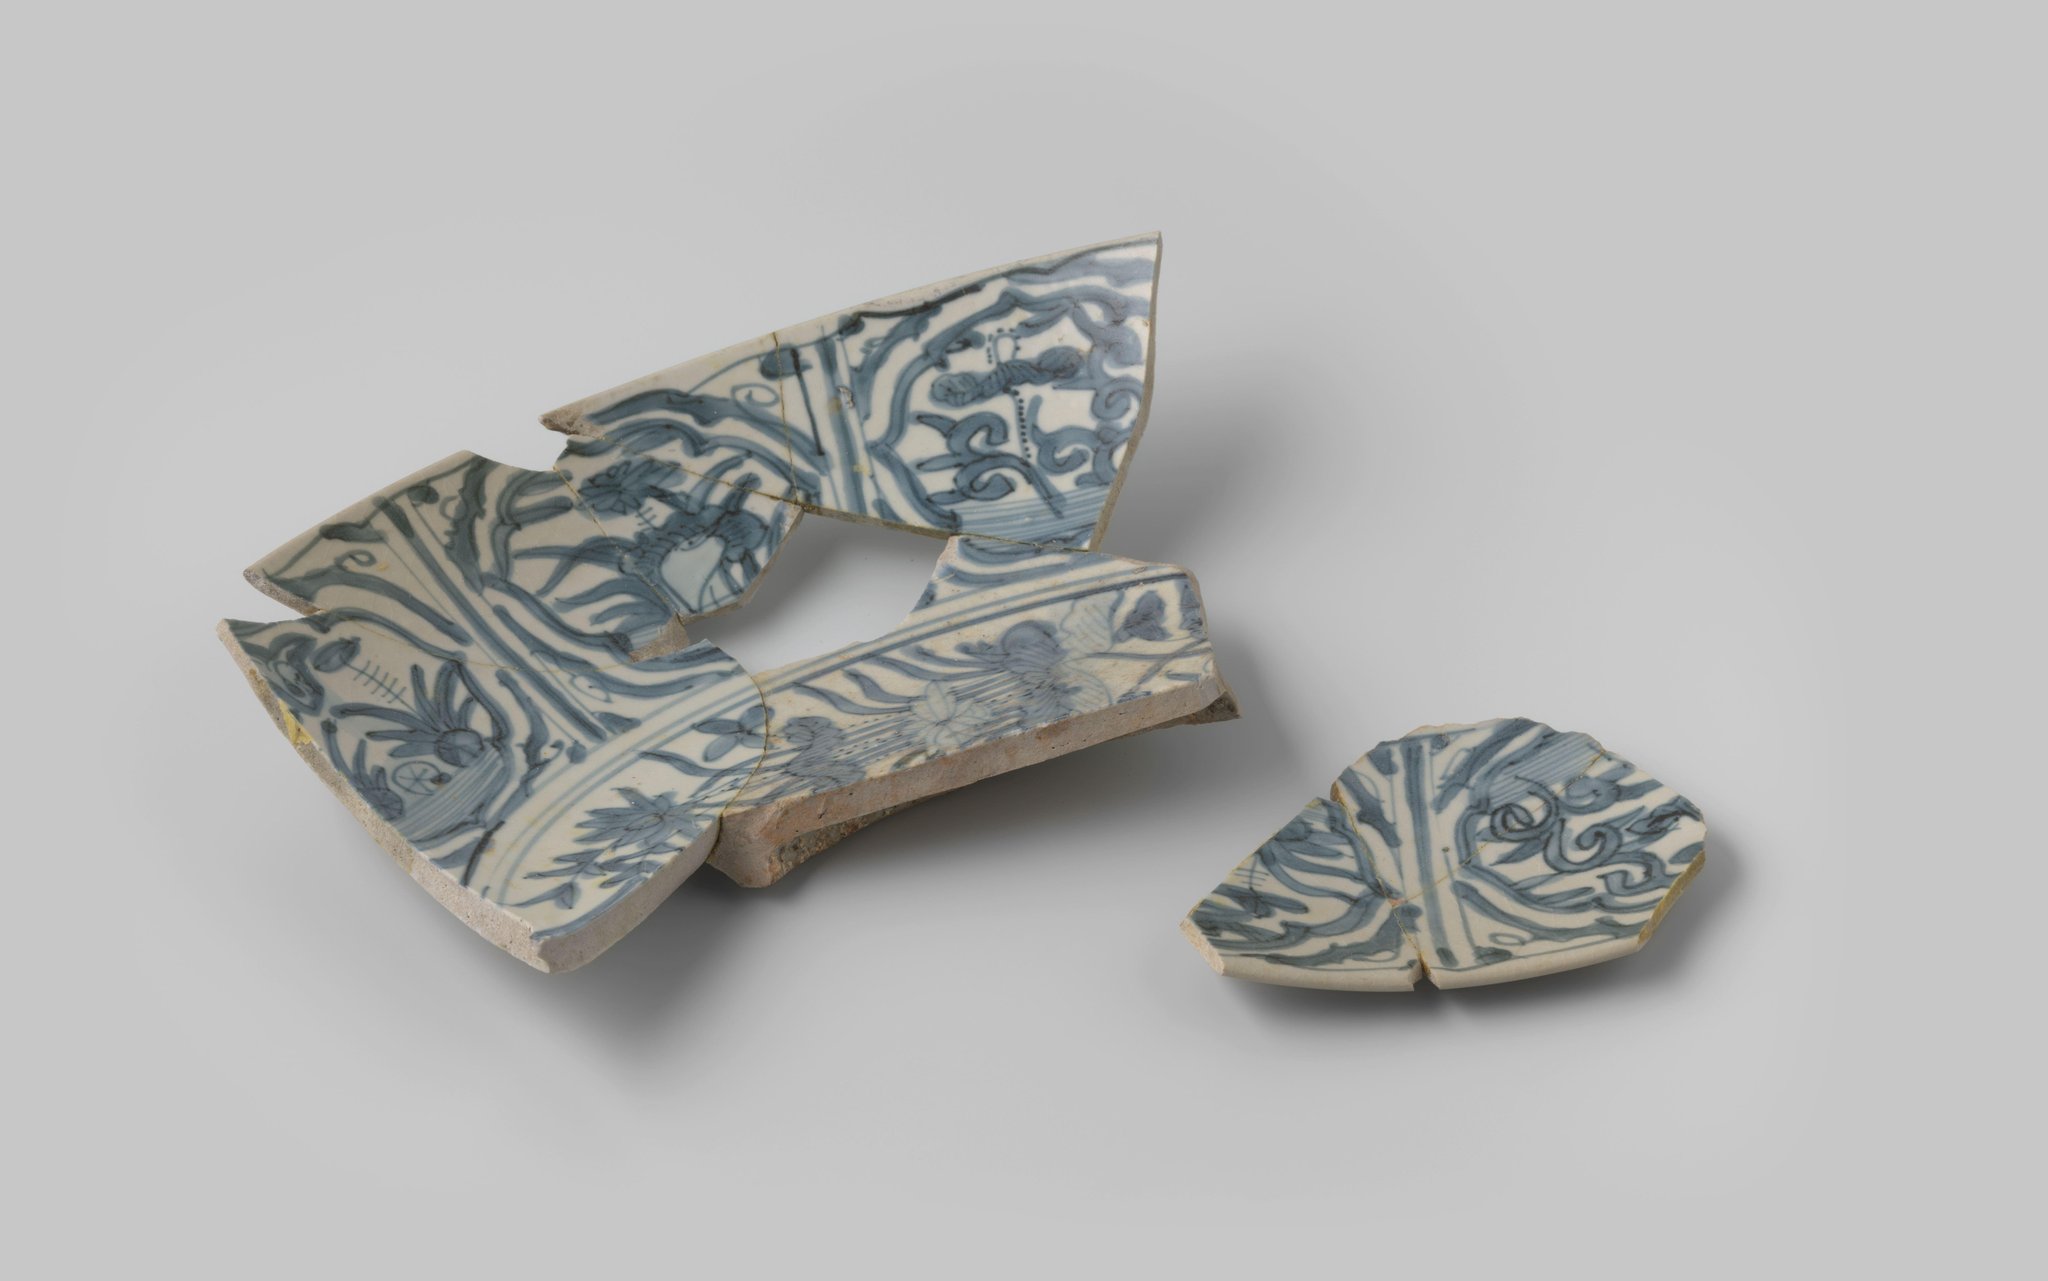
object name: plate dish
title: Scherven van een bord uit V.O.C.-schip de 'Witte Leeuw'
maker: Anonymous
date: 1613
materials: porcelain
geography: shantou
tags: verenigde oostindische compagnie, sint-helena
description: A large dish. In the centre a water landscape with ducks. On the walls medallions with a white frame edged with blue in which a floral design is painted. These are separared by 9 narrow bands. On the outside are two wavy ribbons and a thin band around the lip-rim.